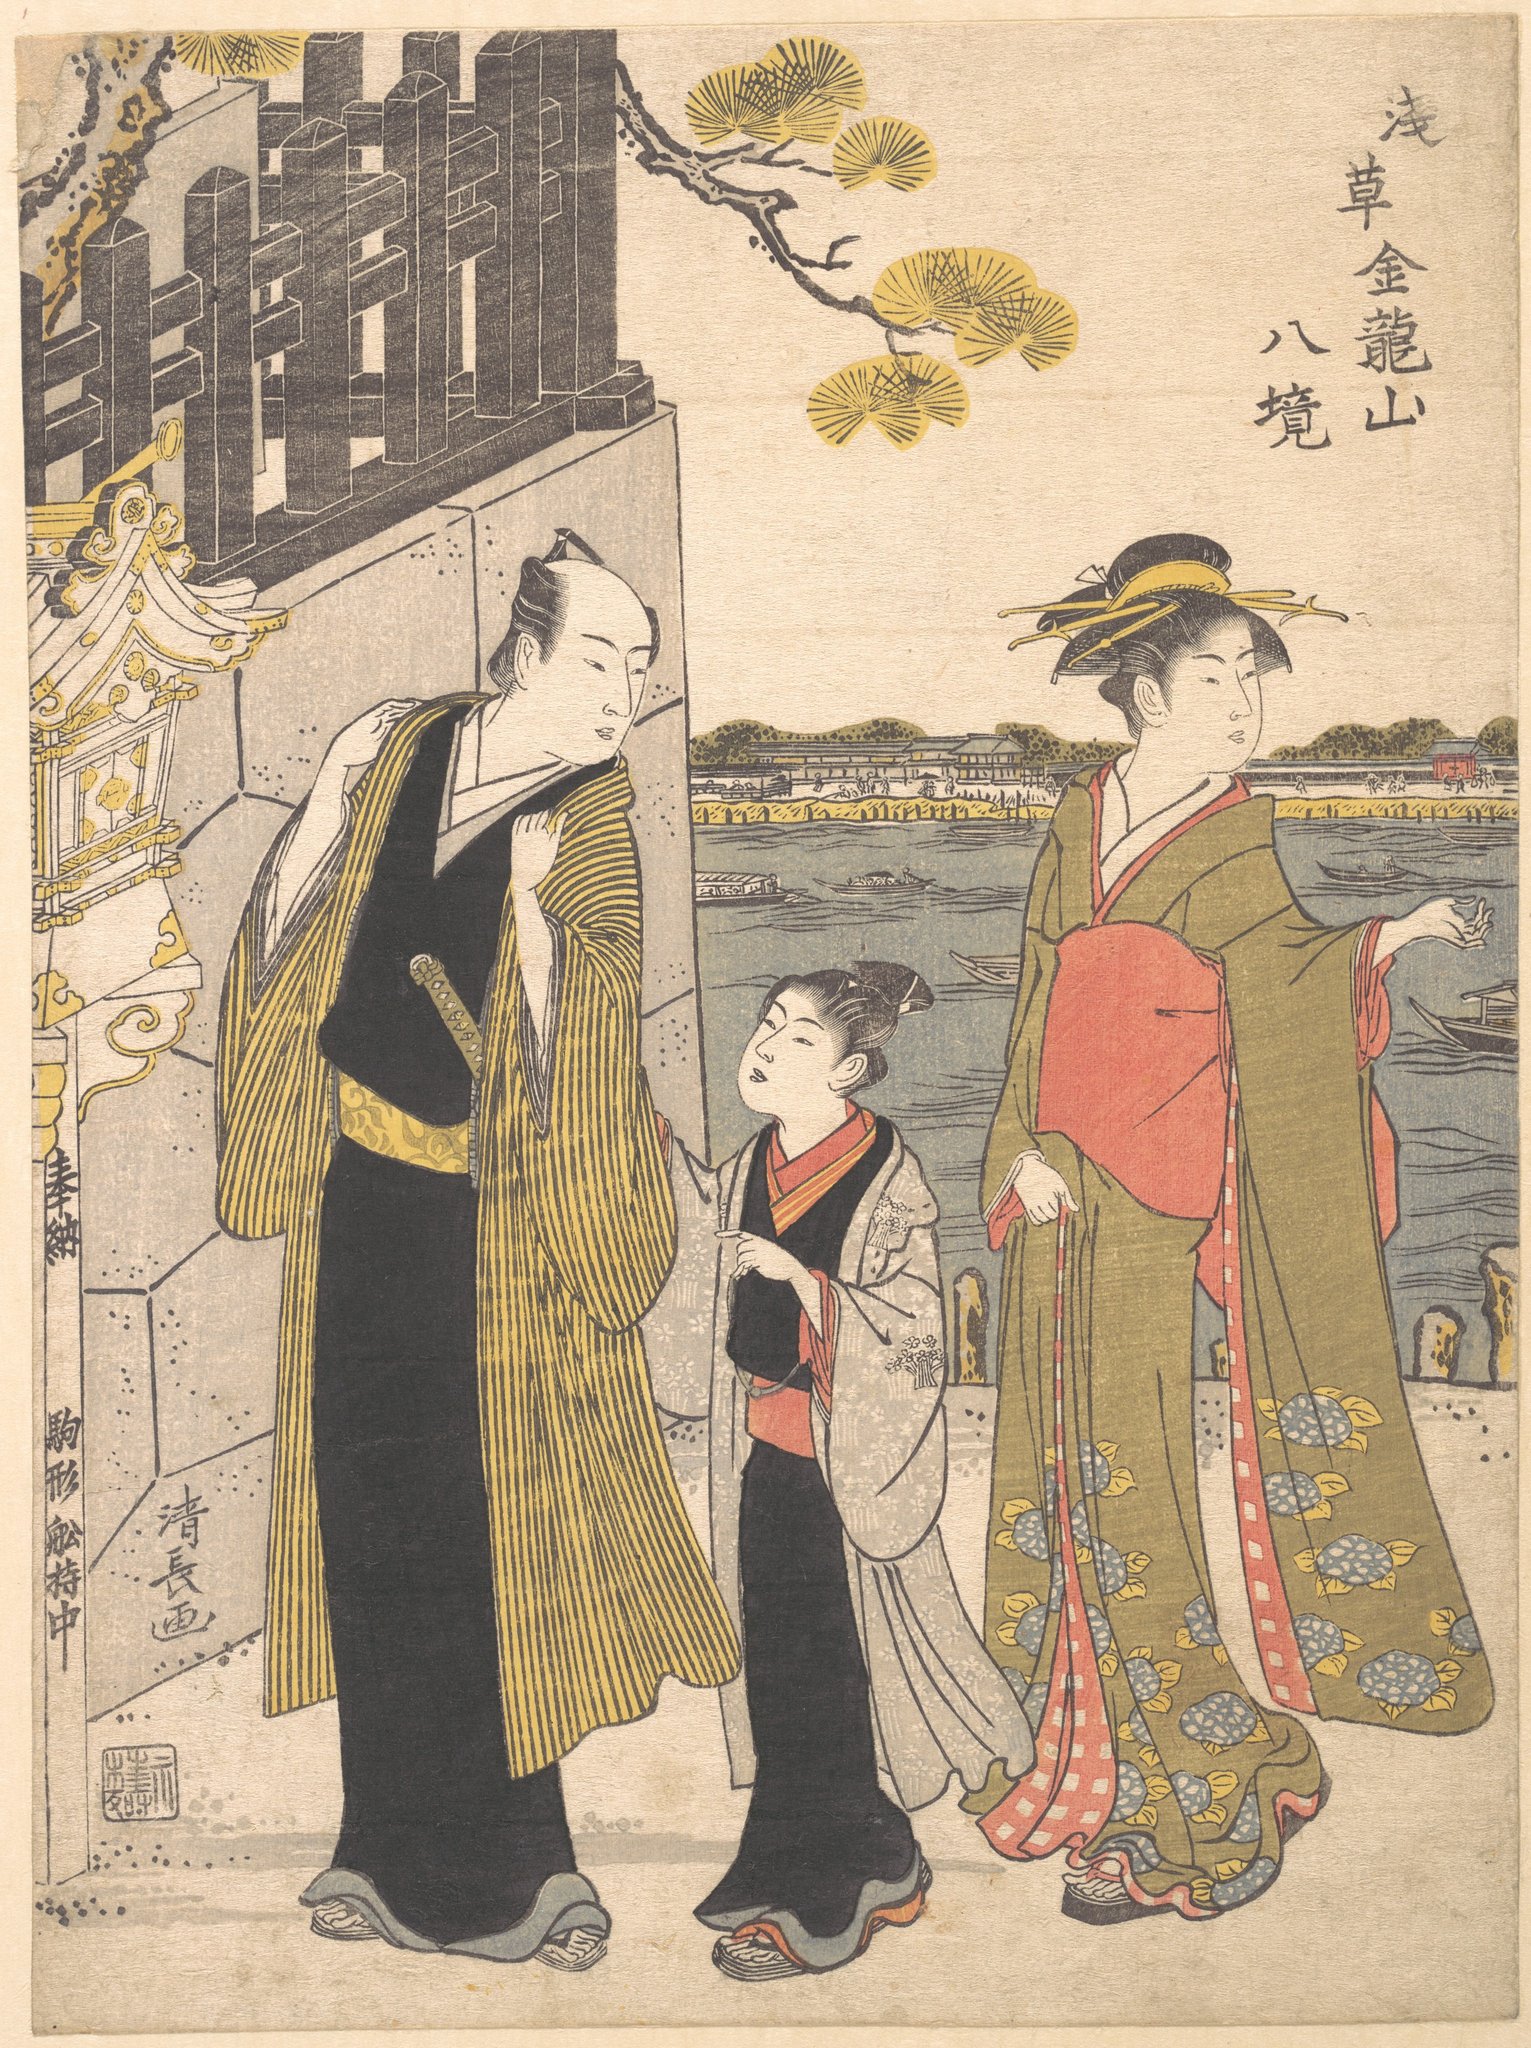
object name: print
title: A Man with a Boy and a Geisha Visiting the Kinryusan Temple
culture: japanese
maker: torii kiyonaga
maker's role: artist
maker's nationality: japanese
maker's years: 1752-1815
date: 1787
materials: ink, paper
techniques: woodblock print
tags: temples,boys,men,women